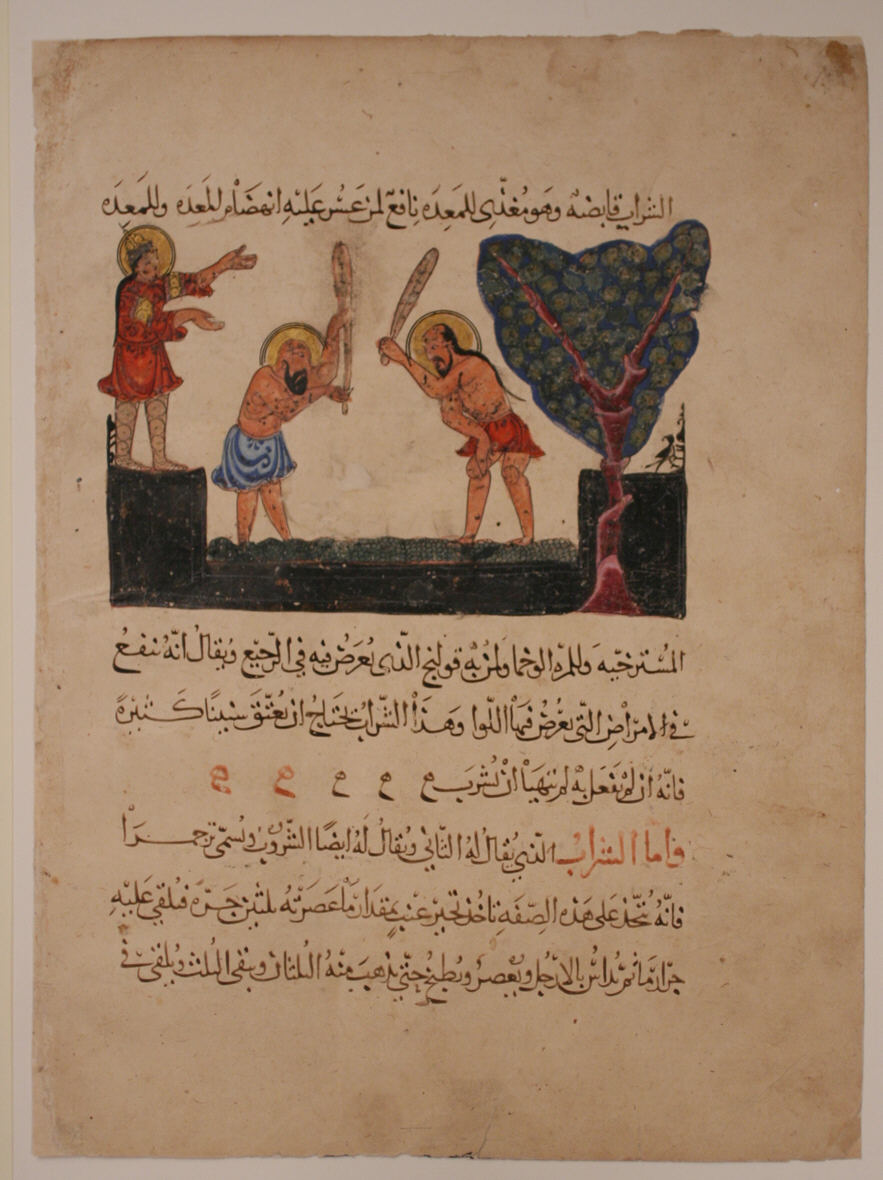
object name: folio from an illustrated manuscript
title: "Men Treading Grapes", Folio from a Materia Medica of Dioscorides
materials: gold, ink, paper, watercolor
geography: iraq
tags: grapes,men